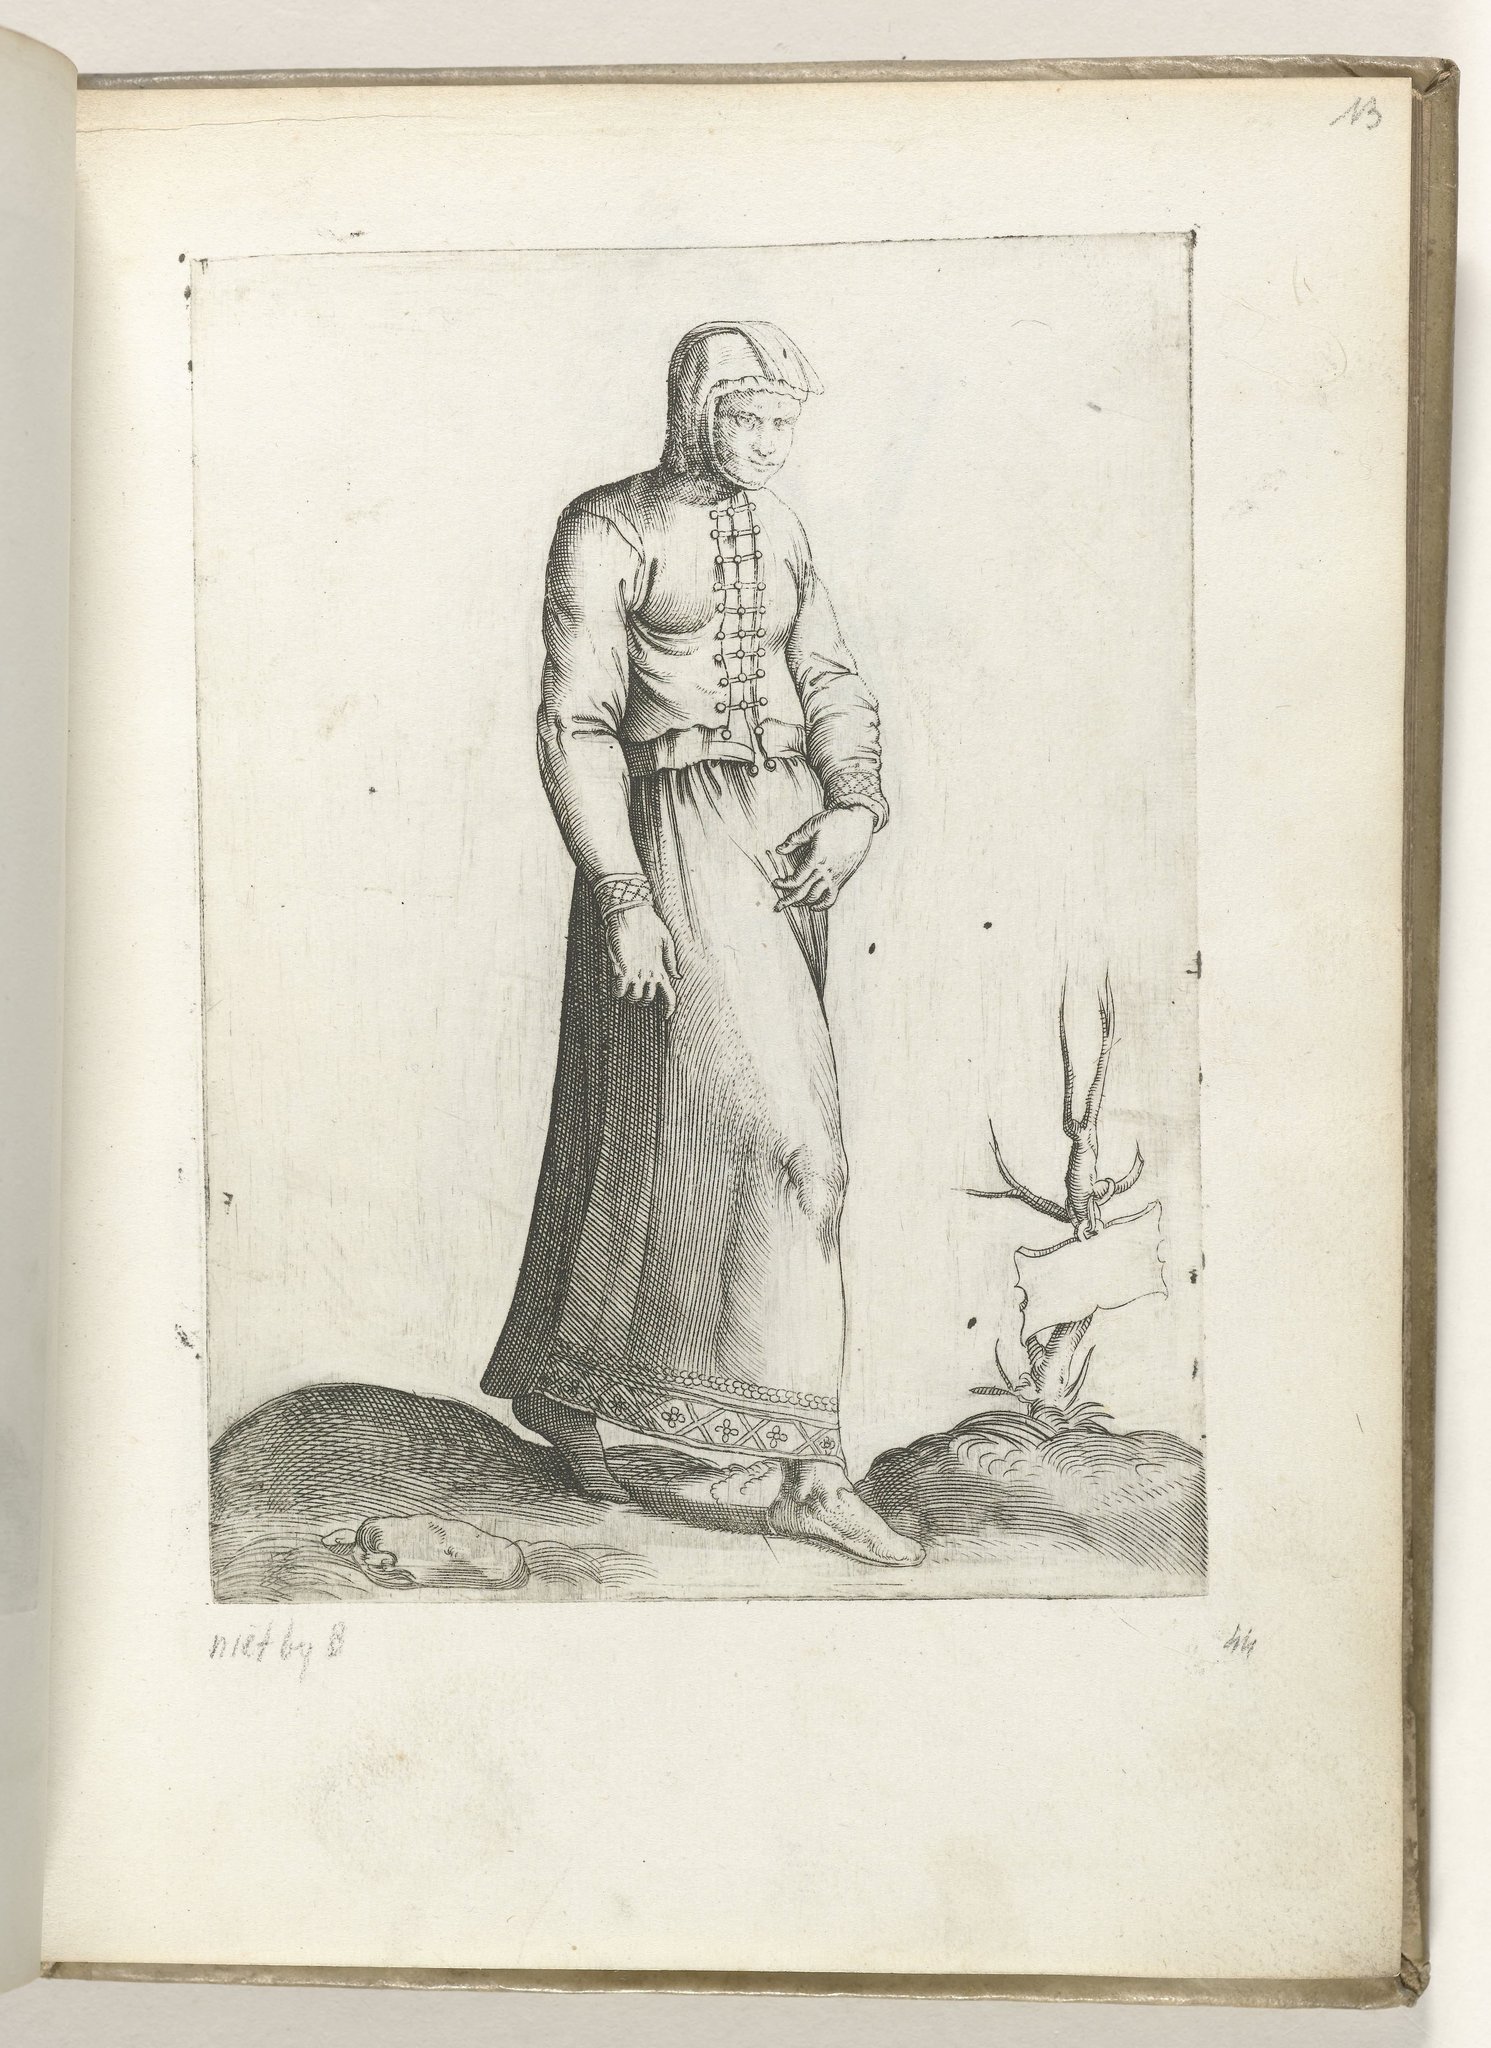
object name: costume print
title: Diversarum gentium nostrae aetatis habitus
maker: enea vico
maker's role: draughtsman, print maker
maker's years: 1523-1567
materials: paper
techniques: engraving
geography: venice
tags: europeans: spaniards (+ costume)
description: Spaanse vrouw naar rechts. Prent zonder titel uit album 'Diversarum gentium nostrae aetatis habitus'.